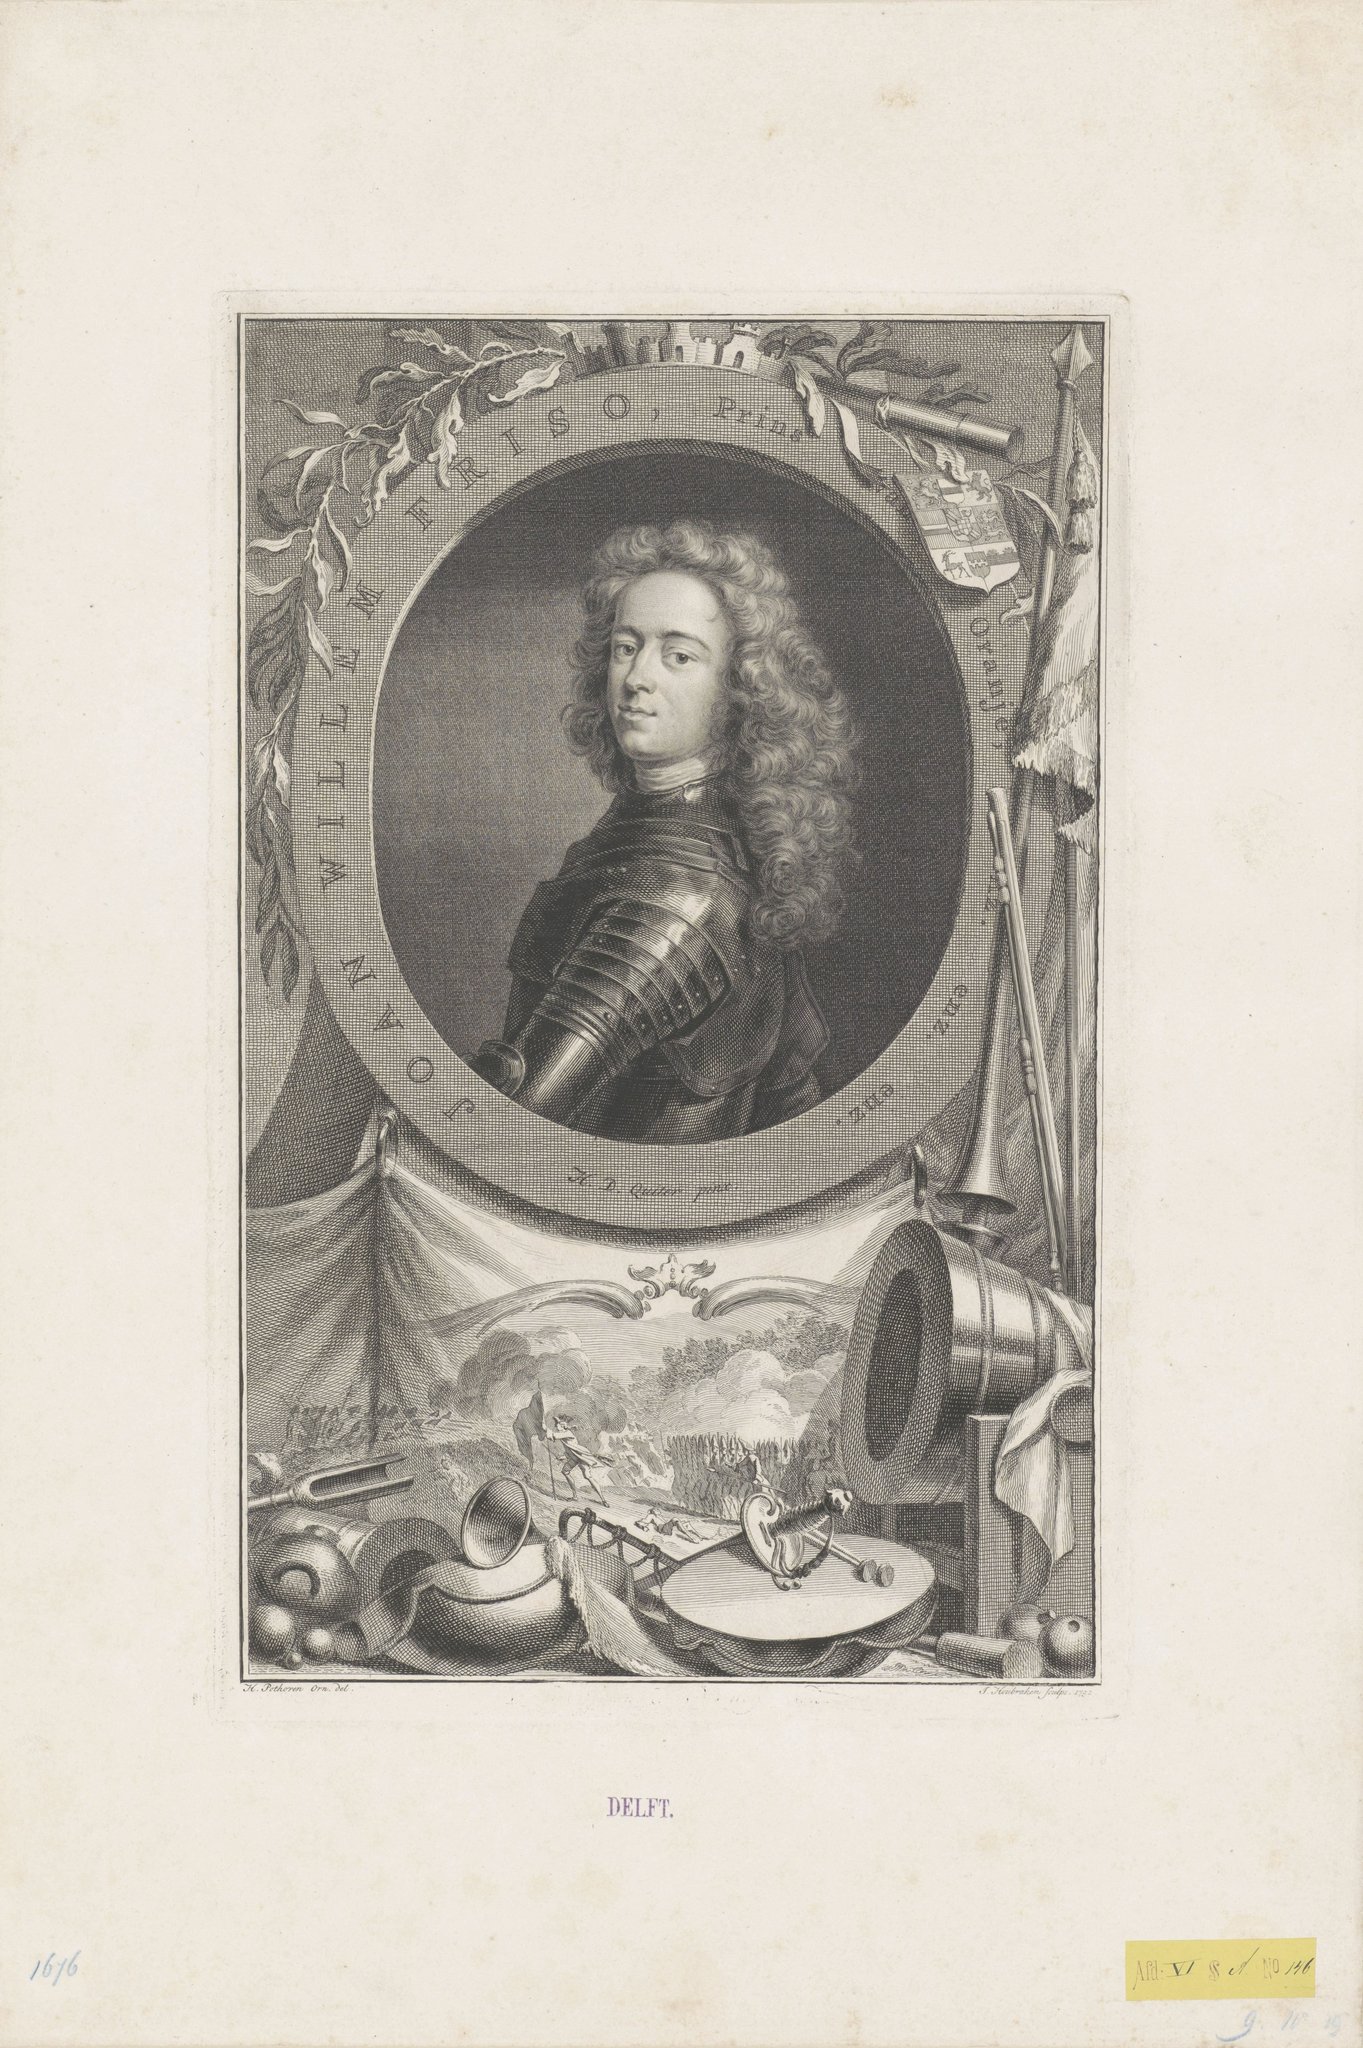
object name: print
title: Portret van Johan Willem Friso, prins van Oranje-Nassau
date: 1752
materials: paper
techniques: engraving, etching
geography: amsterdam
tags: johan willem friso (prins van oranje-nassau)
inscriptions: date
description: Portret van Johan Willem Friso in een ovaal met randschrift. Rondom ligt een aantal allegorische objecten, waaronder een lans, een kanon, een trommel en zijn wapen. Op het reliëf een voorstelling van een veldslag.